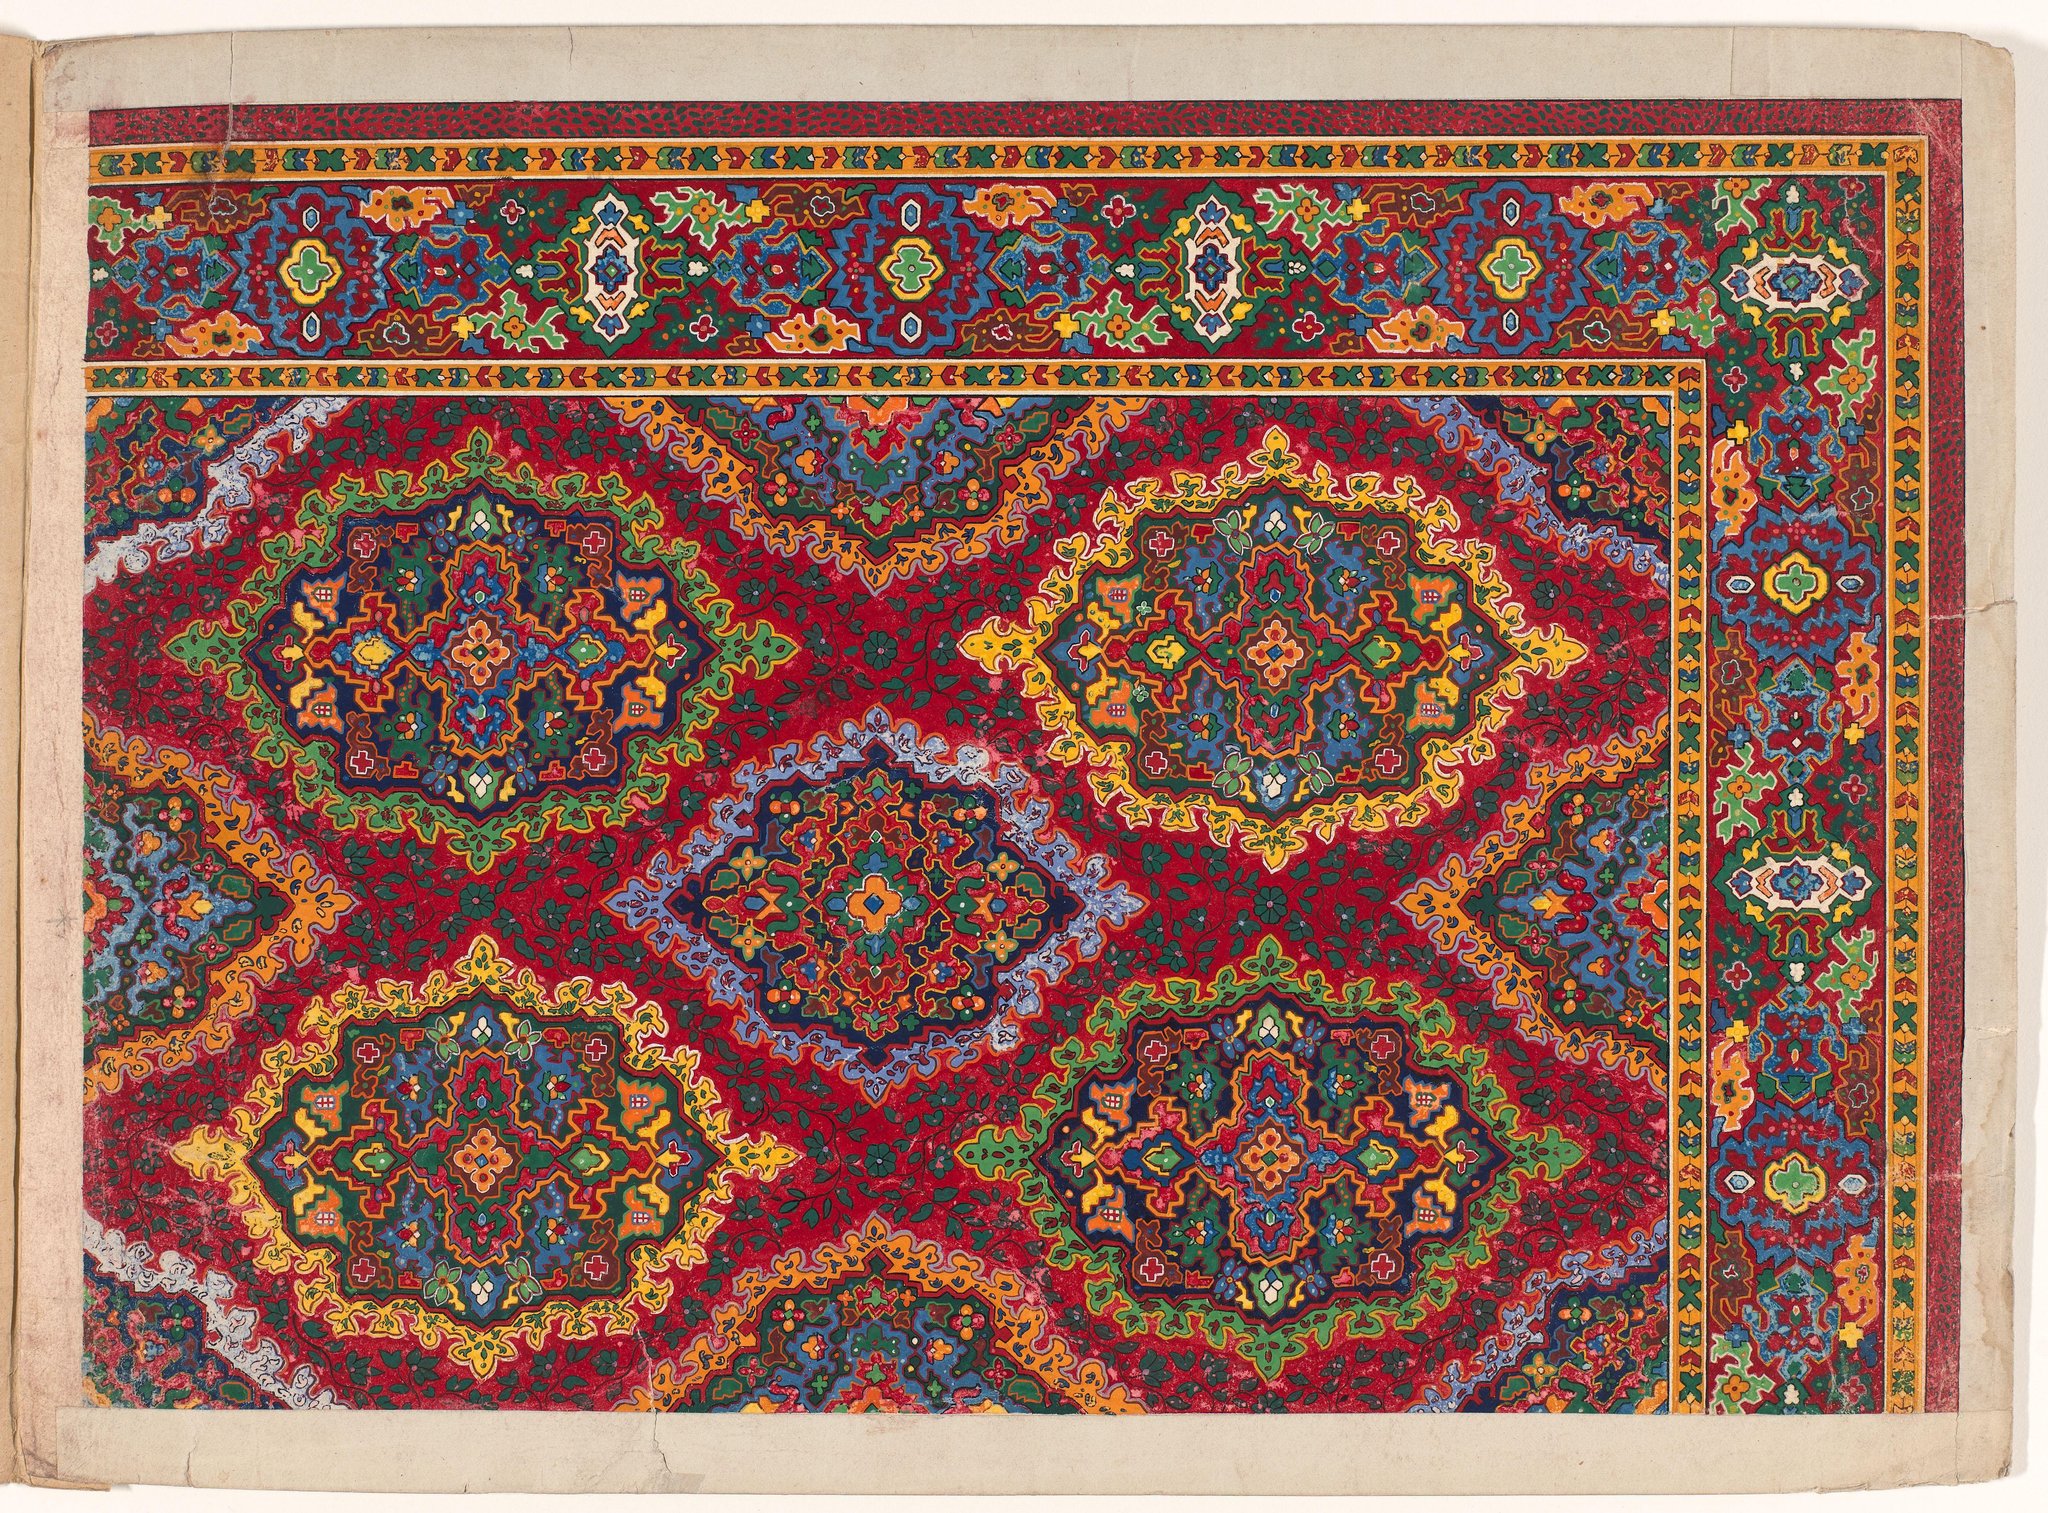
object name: drawing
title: Ontwerp voor een tapijt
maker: Anonymous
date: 1854-1864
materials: gouache, paper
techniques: brush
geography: amsterdam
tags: ornaments ~ art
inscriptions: retailer's mark: ‘JHS.’, number: ‘No 359.’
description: De presentatietekeningen BK-1971-77-1 t/m 86 zijn kopieën van de originele ontwerptekeningen. Ze werden gemaakt voor vertegenwoordigers van bijvoorbeeld magazijnen, die ze aan hun klanten konden tonen. De meeste tekeningen tonen een kwart van het dessin inclusief rand, middenpartij (de zogenaamde grond of fond) en centraal medaillon. Door het gebruik van spiegels kan de illusie van het gehele tapijt worden opgeroepen. Een deel van de tekeningen heeft een alfabetische opeenvolgende letter als kenmerk, de andere groep een cijfer.Waarschijnlijk is de reeks dessins met een letter eerder samengesteld dan de genummerde tekeningen.